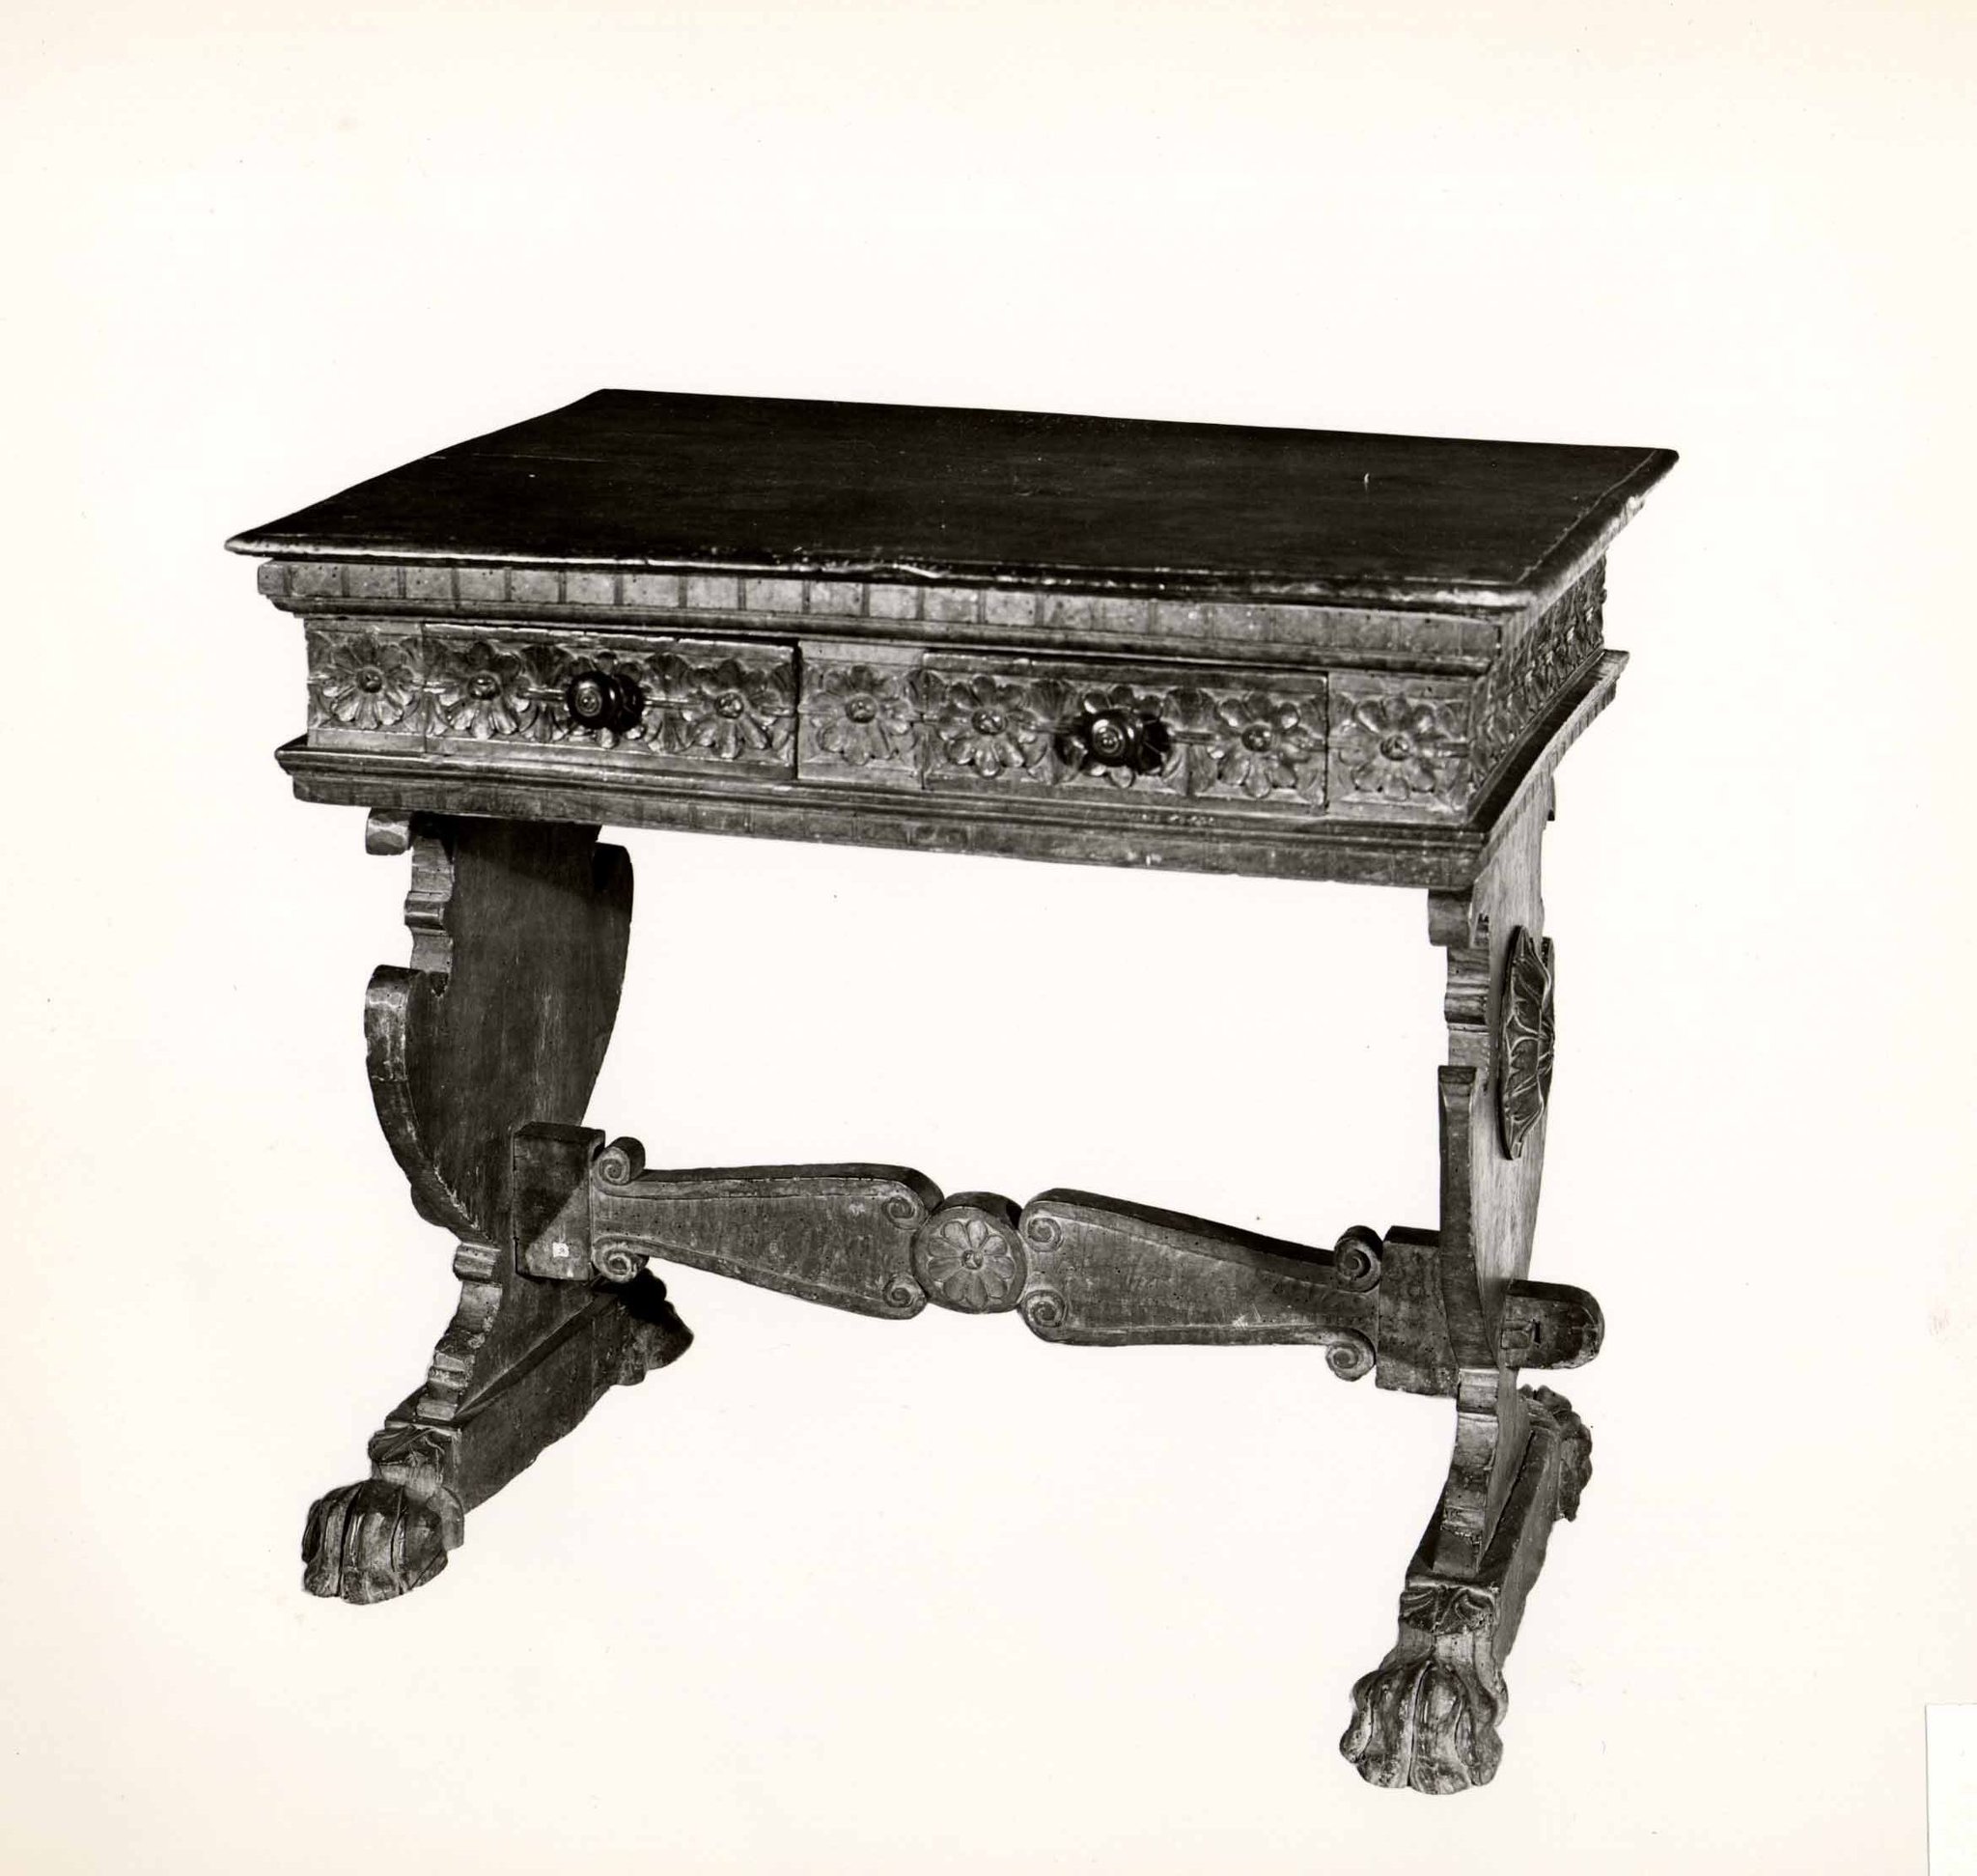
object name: table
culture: italian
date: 1501-1600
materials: wood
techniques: carving